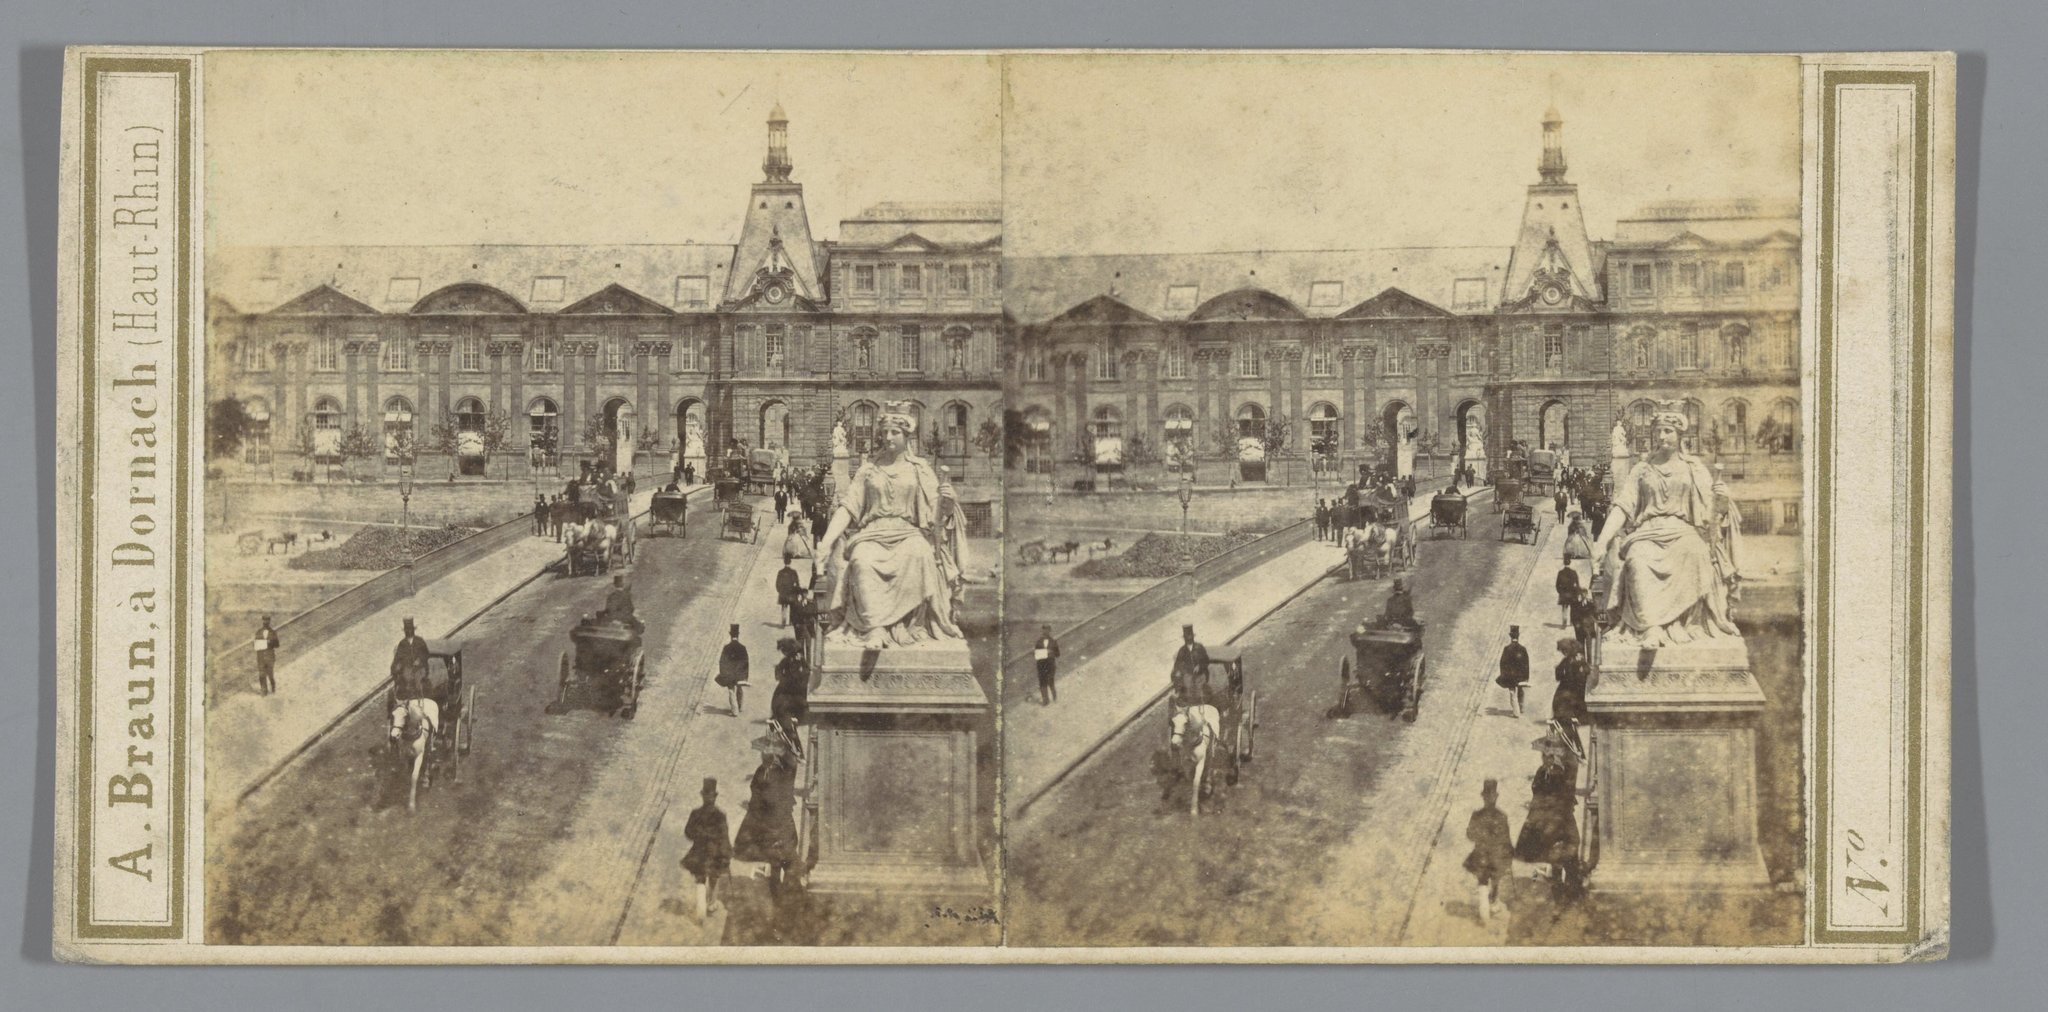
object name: stereograph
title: Pont des Saints-Pères, vue instantanée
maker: Anonymous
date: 1860-1866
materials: cardboard, paper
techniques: albumen print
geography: dornach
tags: bridge in city across river, canal, etc.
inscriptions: number: ‘No 1751.’